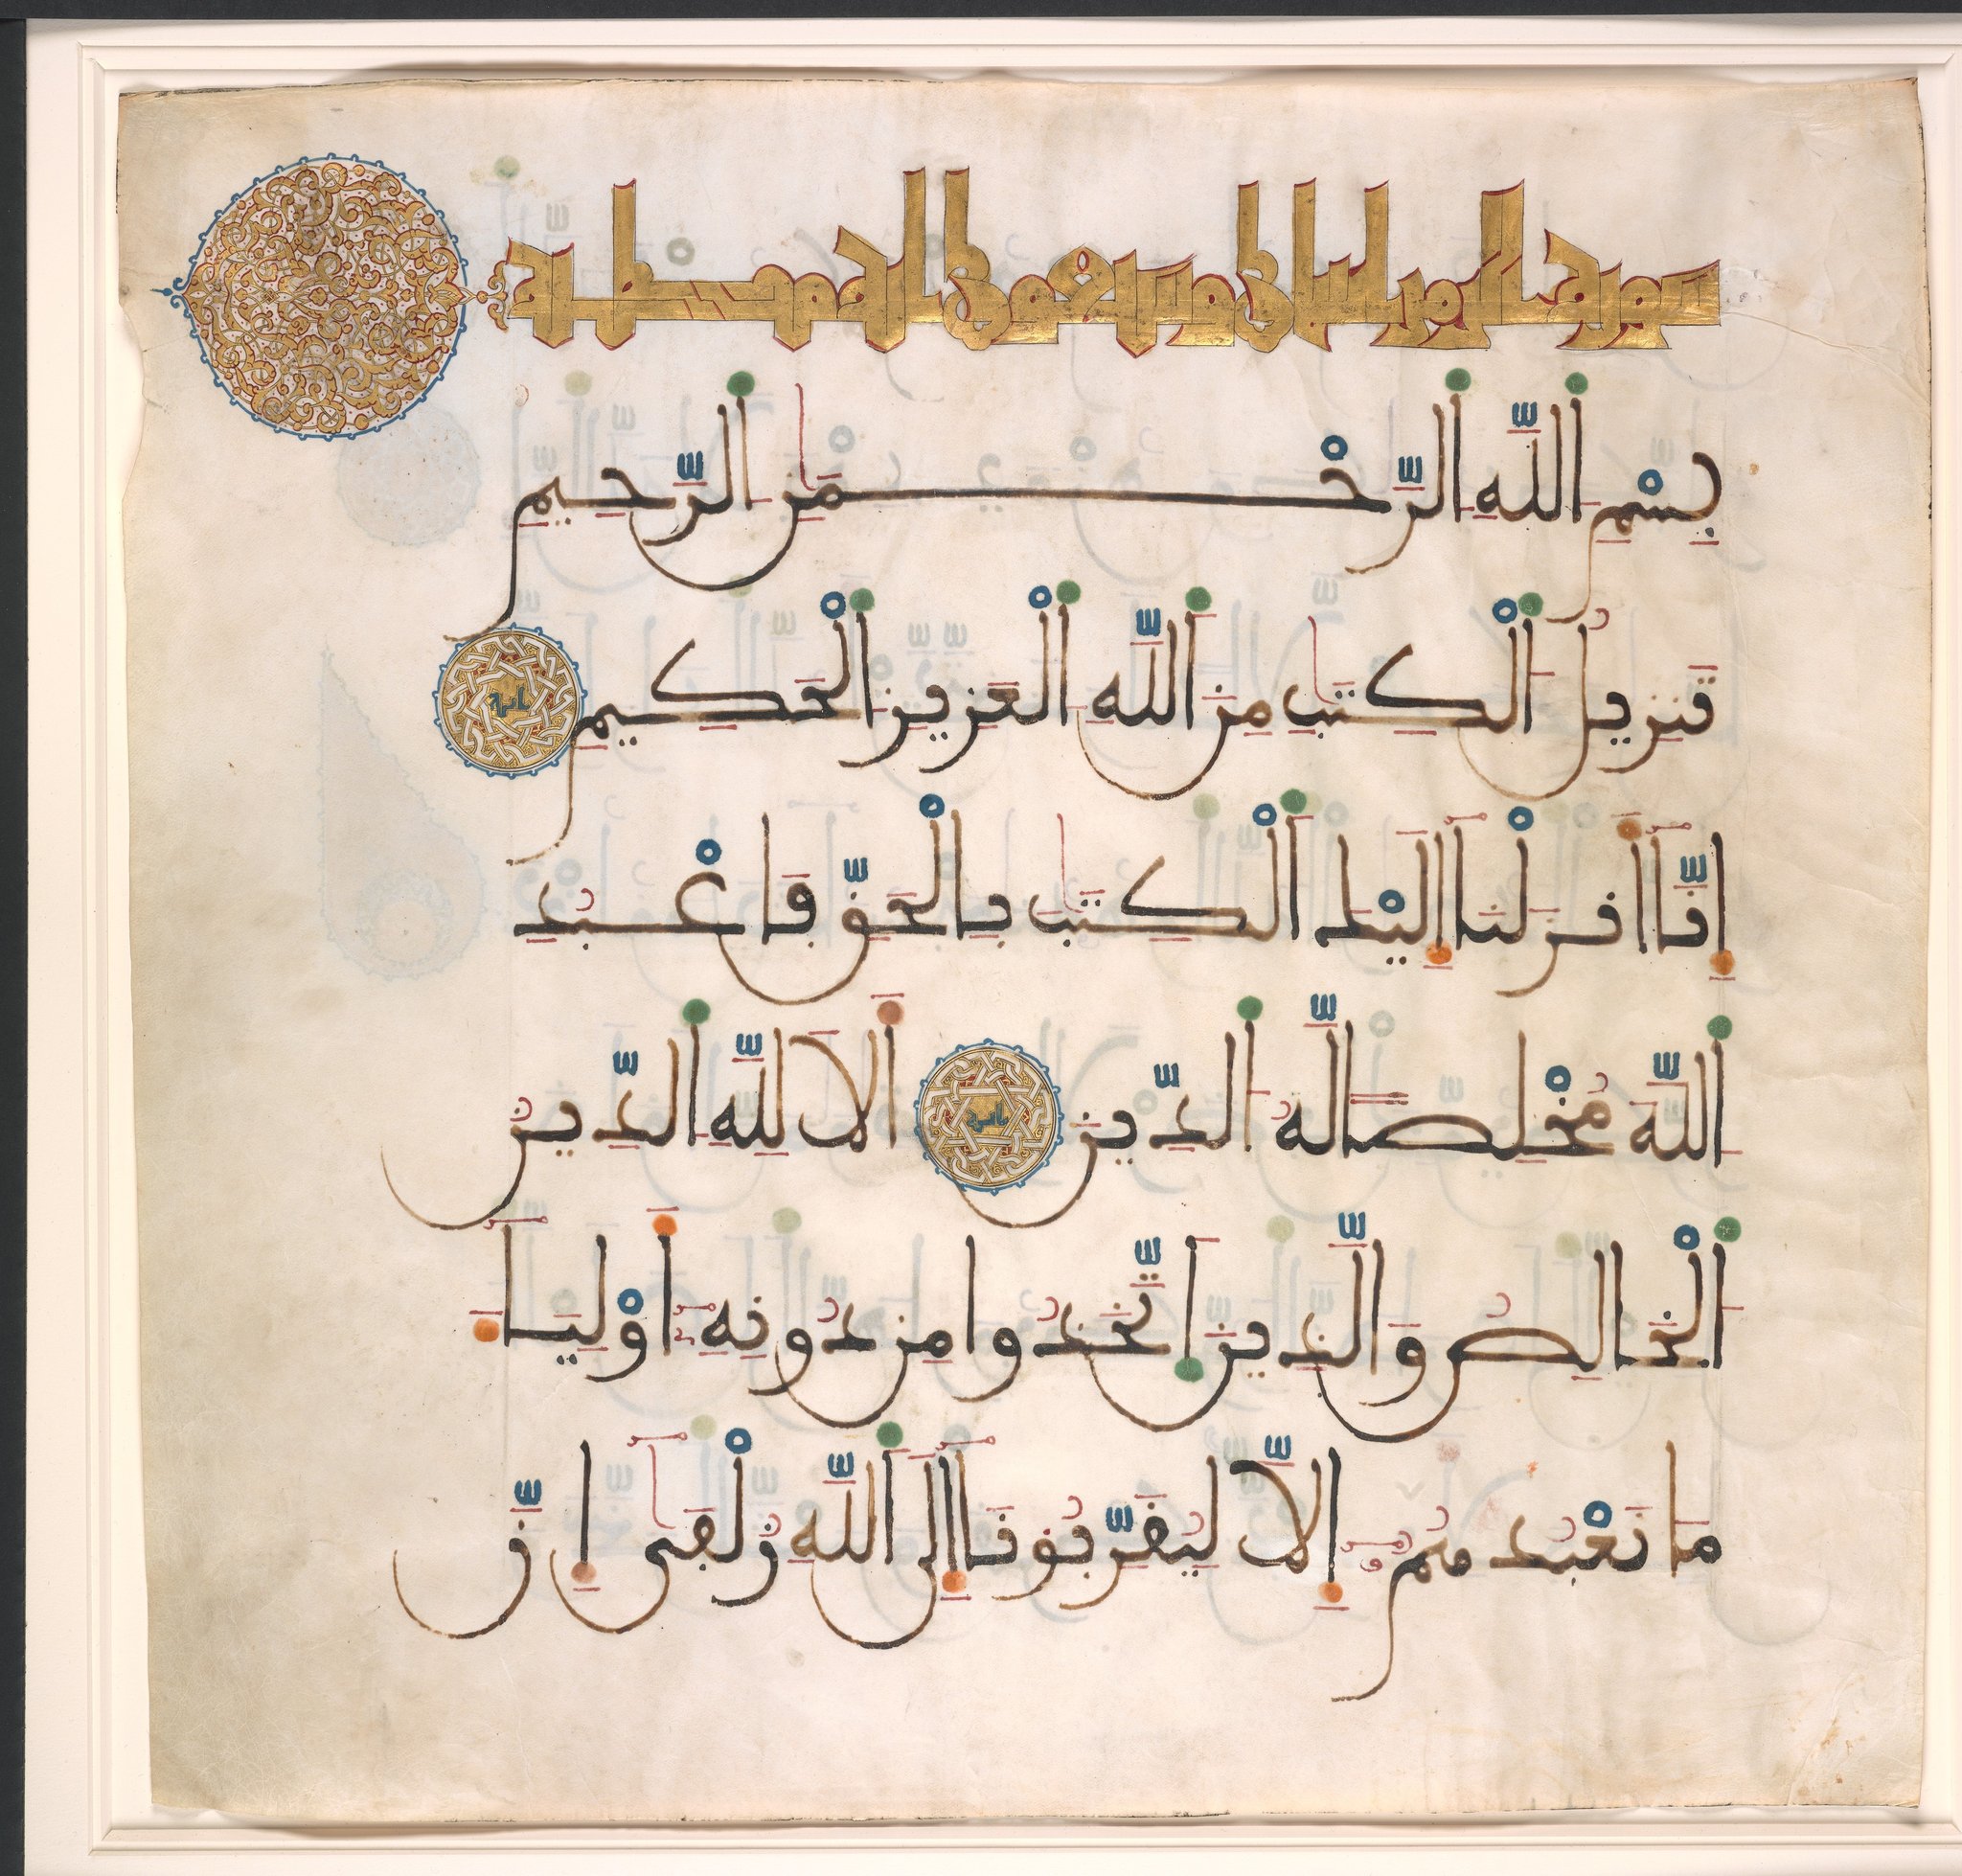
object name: folio from a non illustrated manuscript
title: Folio from a Qur'an Manuscript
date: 1267-1333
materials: gold, ink, parchment, watercolor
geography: spain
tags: qur'an,calligraphy